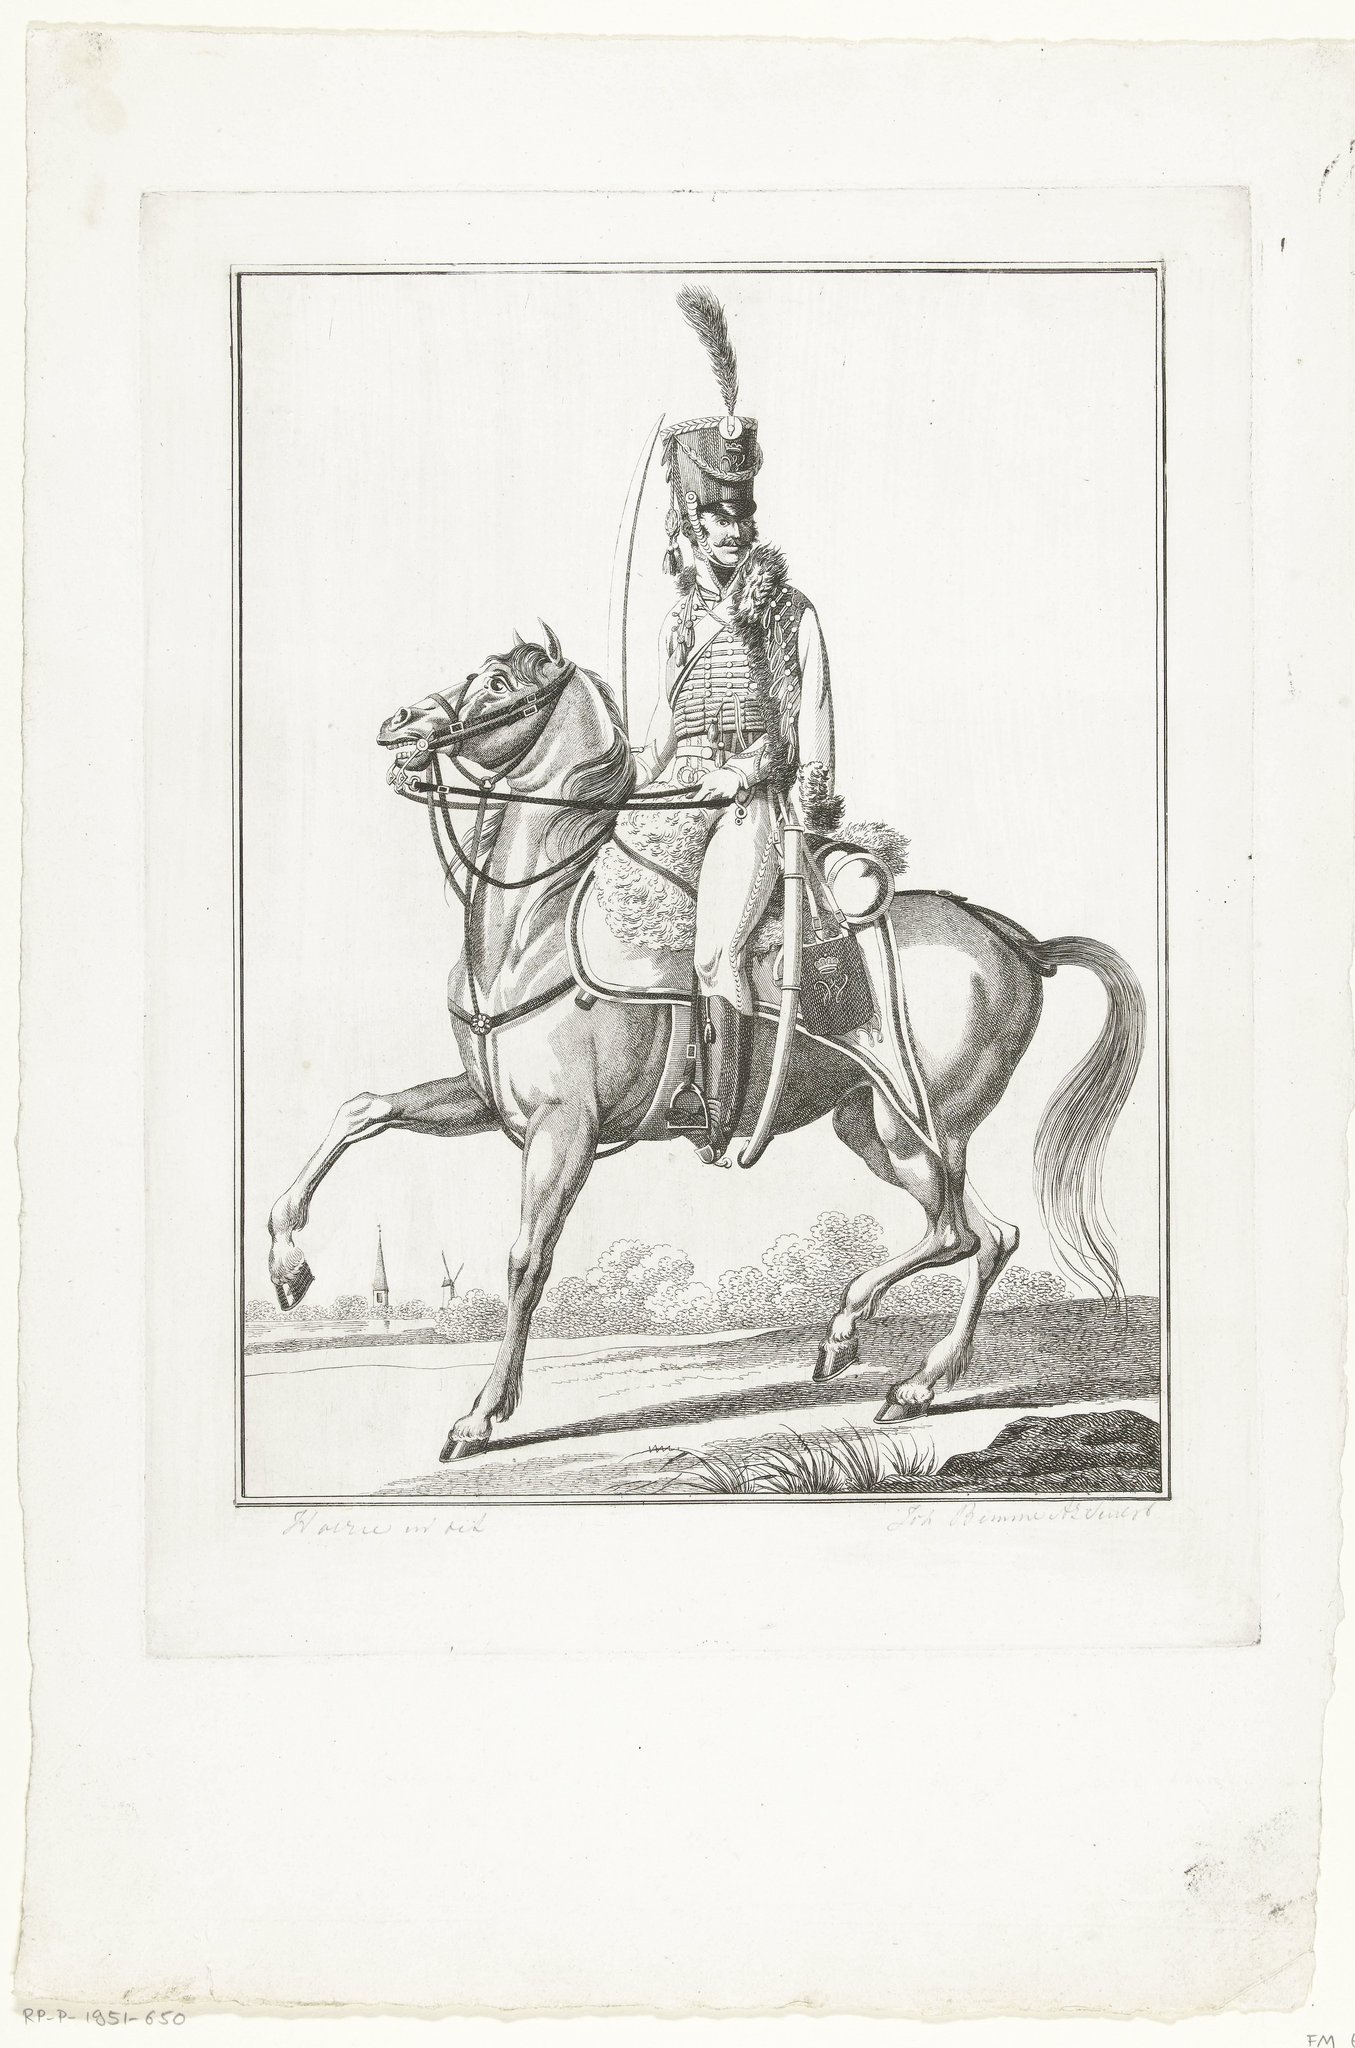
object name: print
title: Huzaar te paard met sabel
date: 1800-1841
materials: paper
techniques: etching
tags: warfare; military affairs (+ cavalry, horsemen)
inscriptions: collector's mark: Lugt 2228